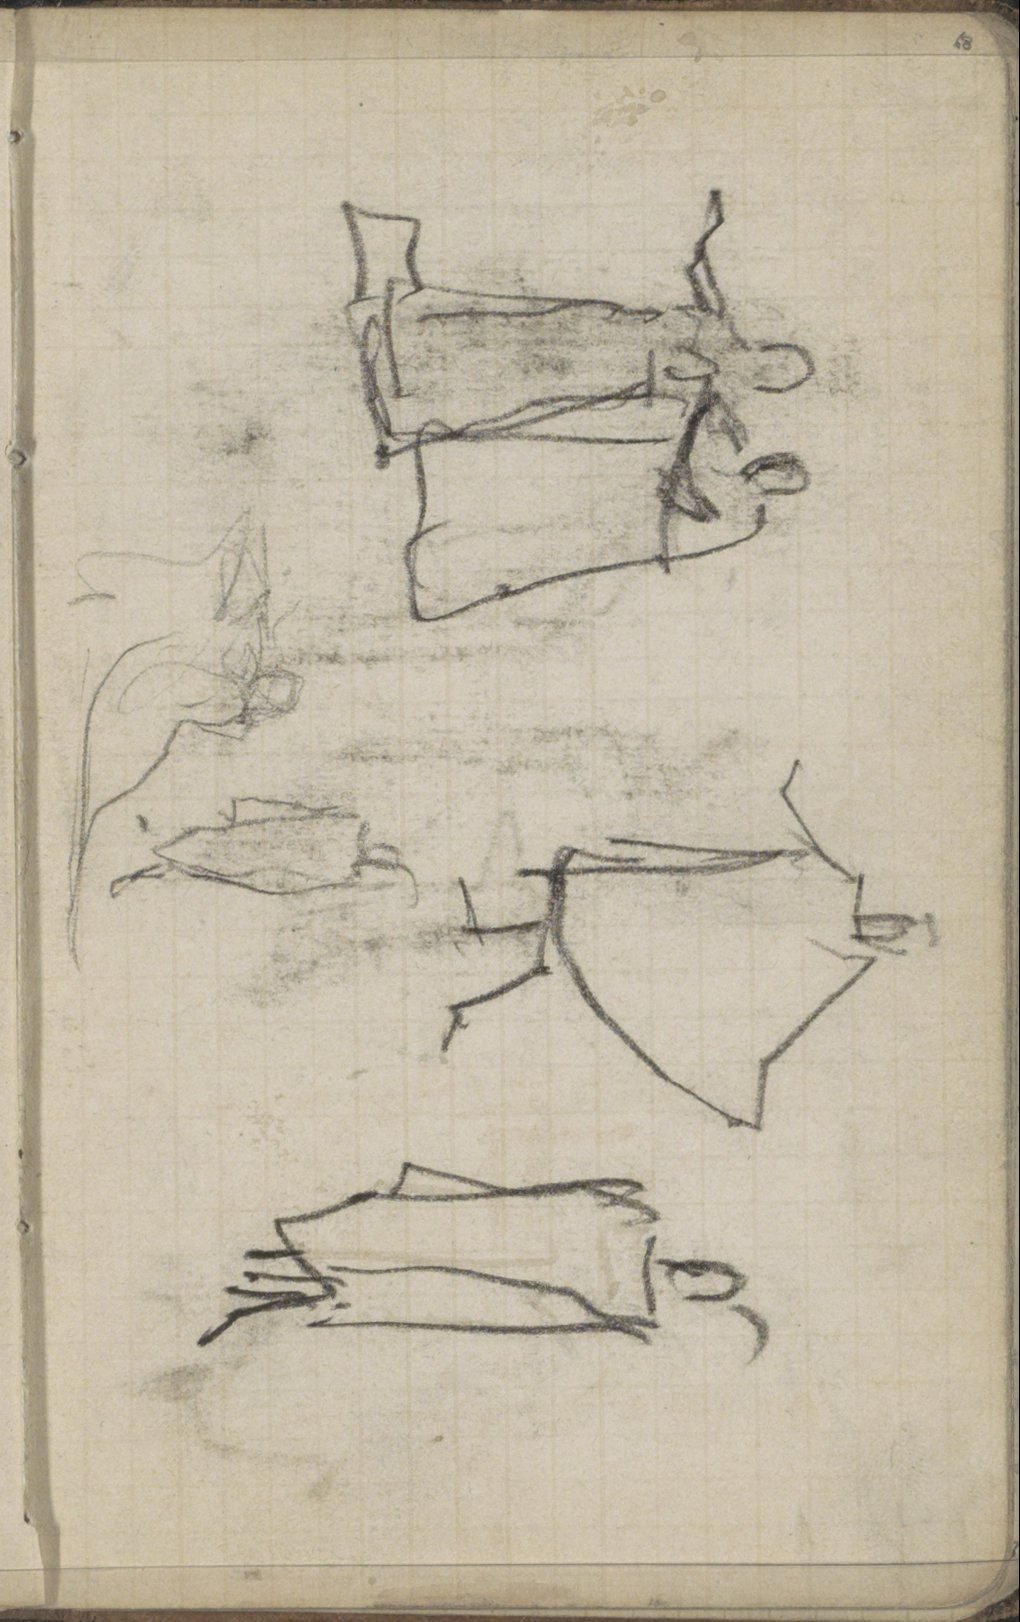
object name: sketchbook leaf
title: Figuurstudies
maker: marius bauer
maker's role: draughtsman, print maker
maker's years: 1867-1932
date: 1879-1885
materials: chalk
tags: standing figure, historical costume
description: Enkele figuren dragen toga's. Pagina 68 uit een schetsboek met 58 bladen.